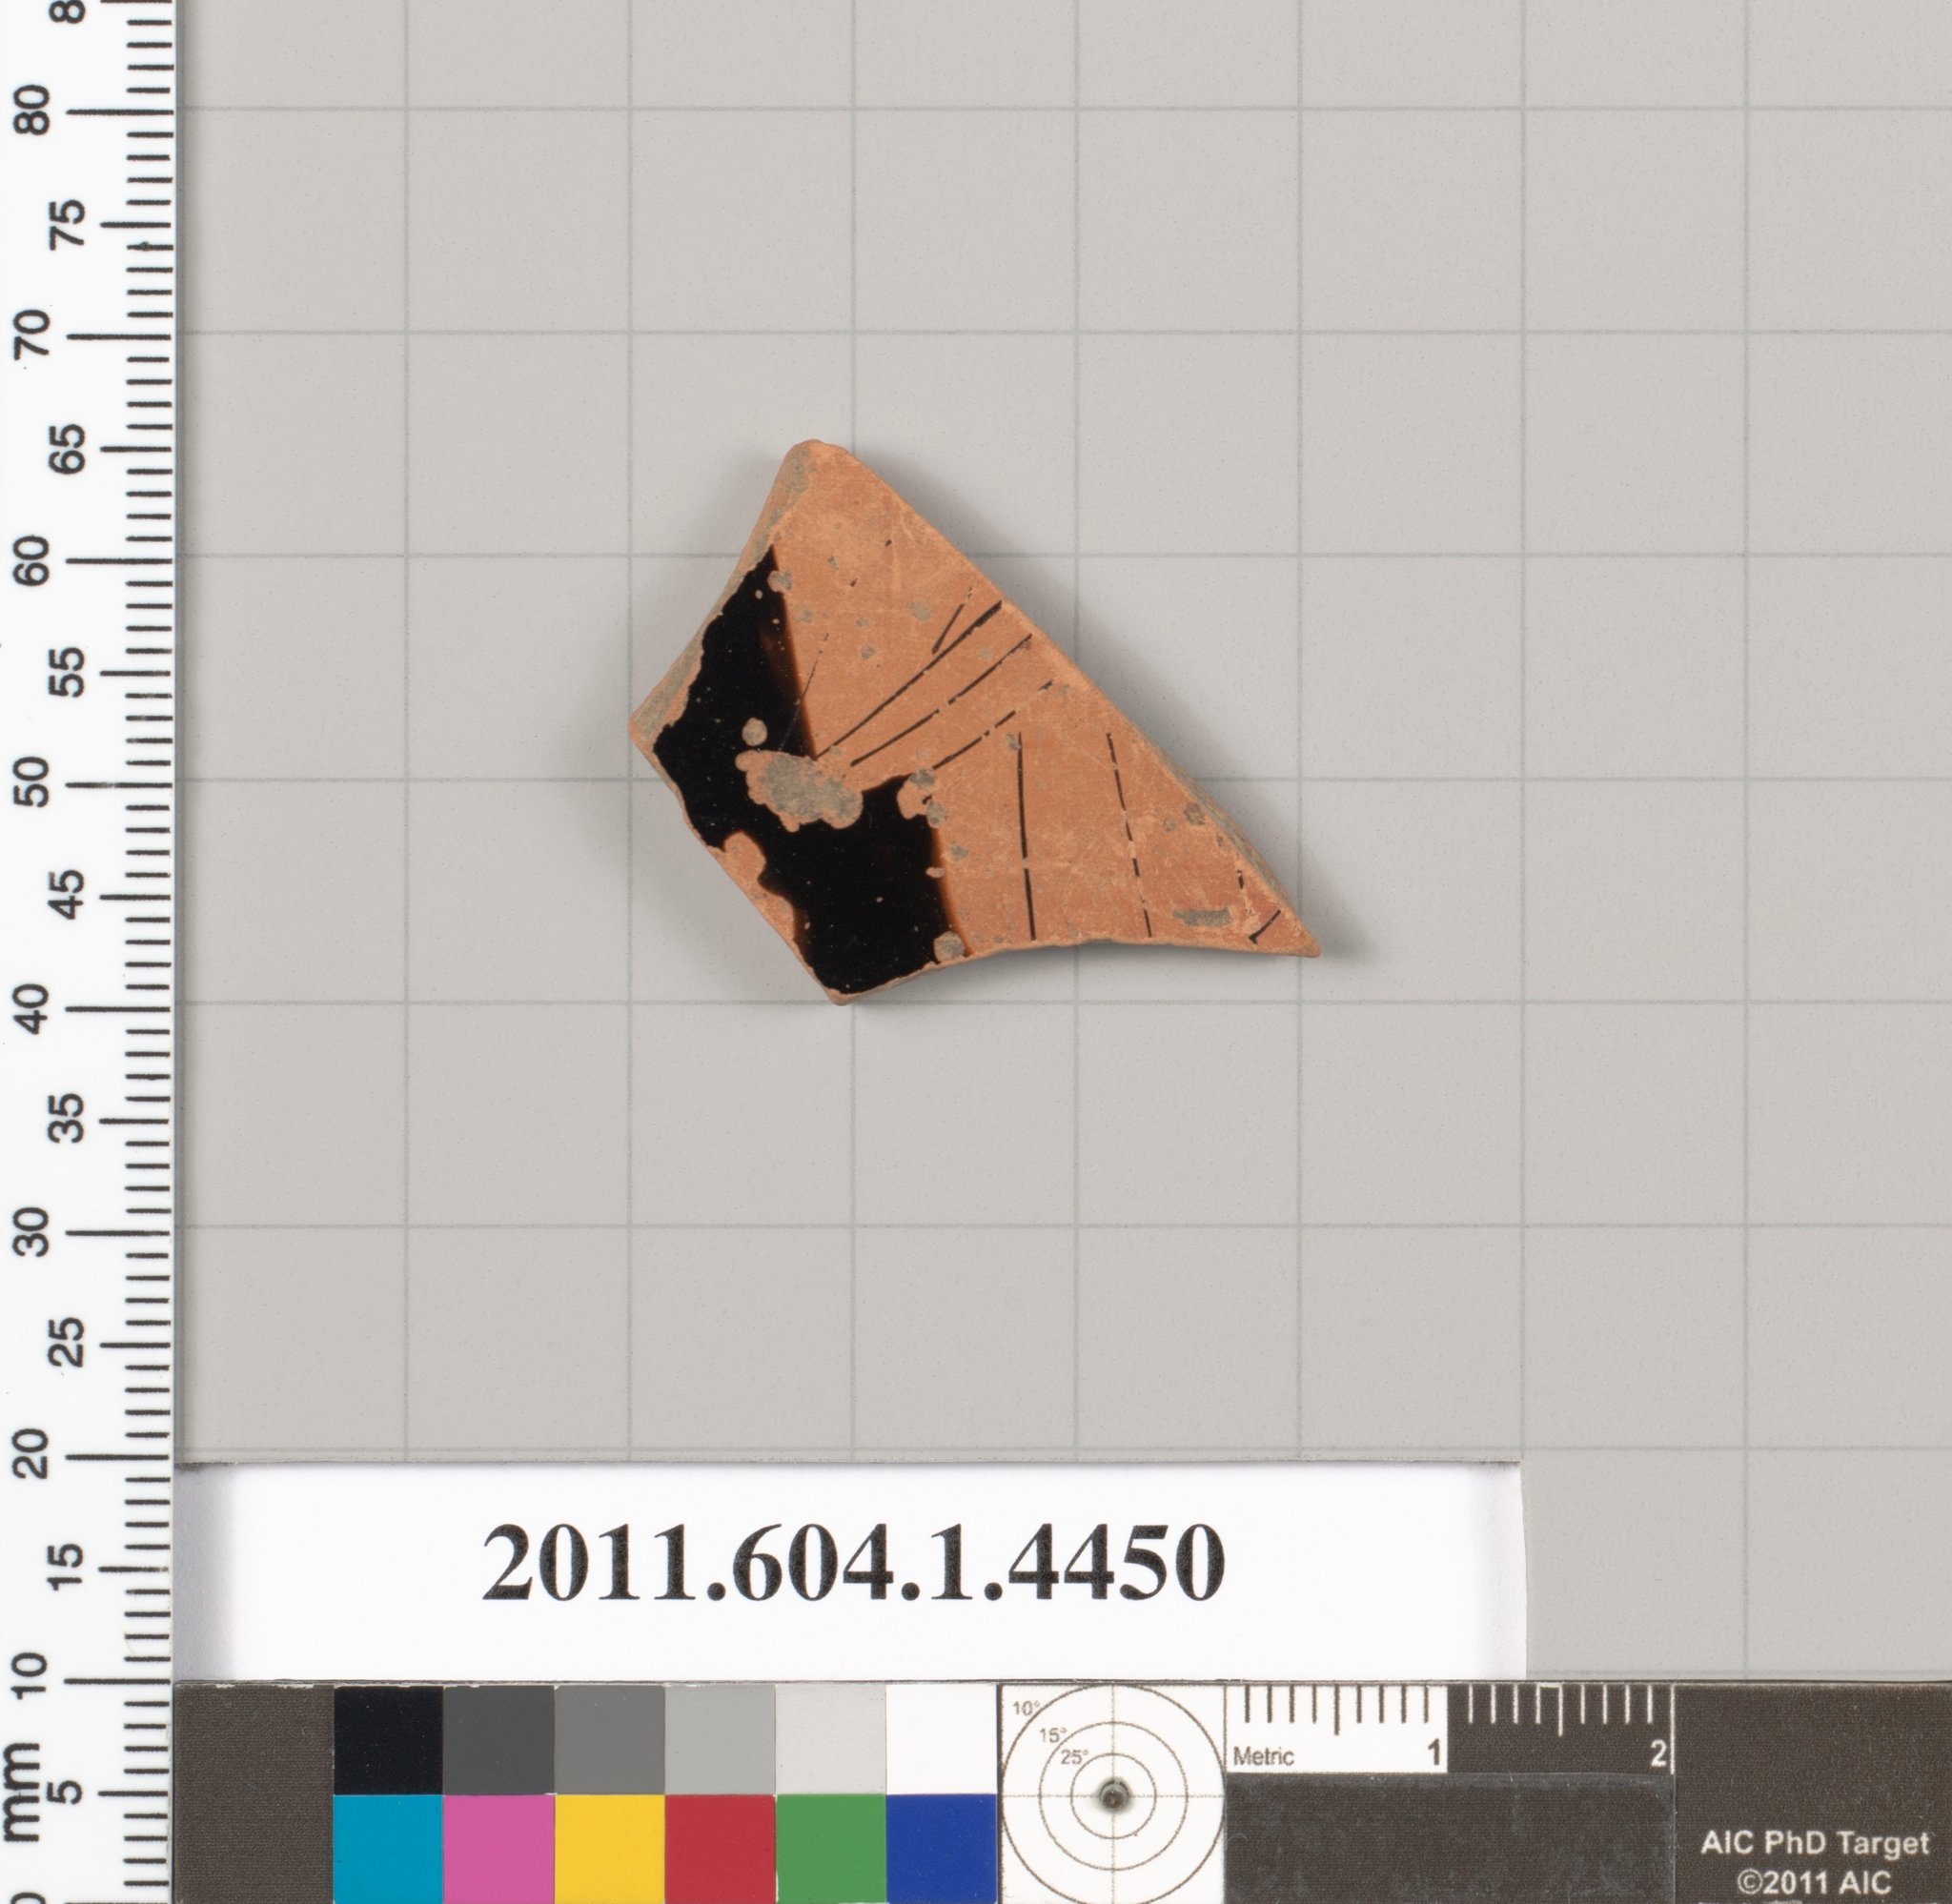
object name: kylix fragment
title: Terracotta fragment of a kylix (drinking cup)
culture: greek, attic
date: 475-451 BCE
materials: terracotta